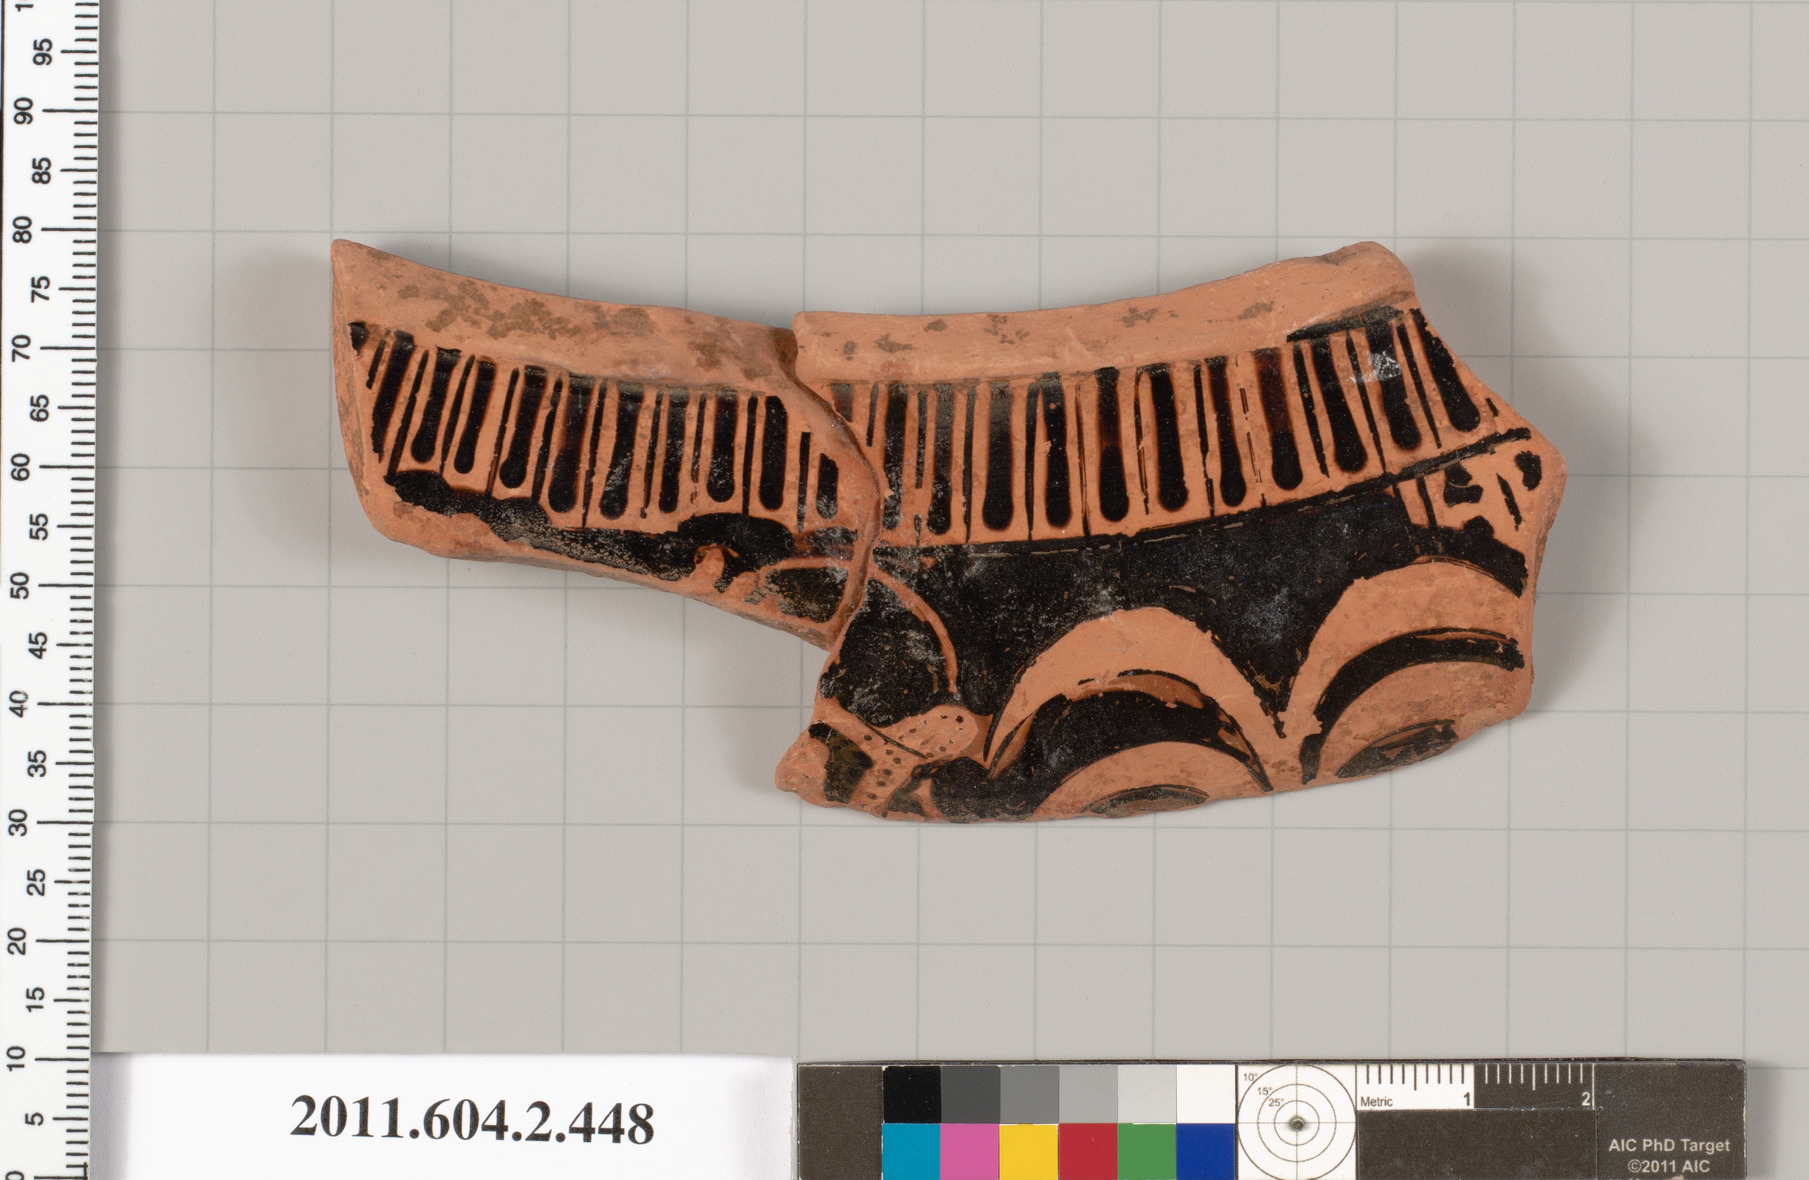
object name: column krater fragment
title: Terracotta fragment of a column-krater (bowl for mixing wine and water)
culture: greek, attic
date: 460-440 BCE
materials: terracotta